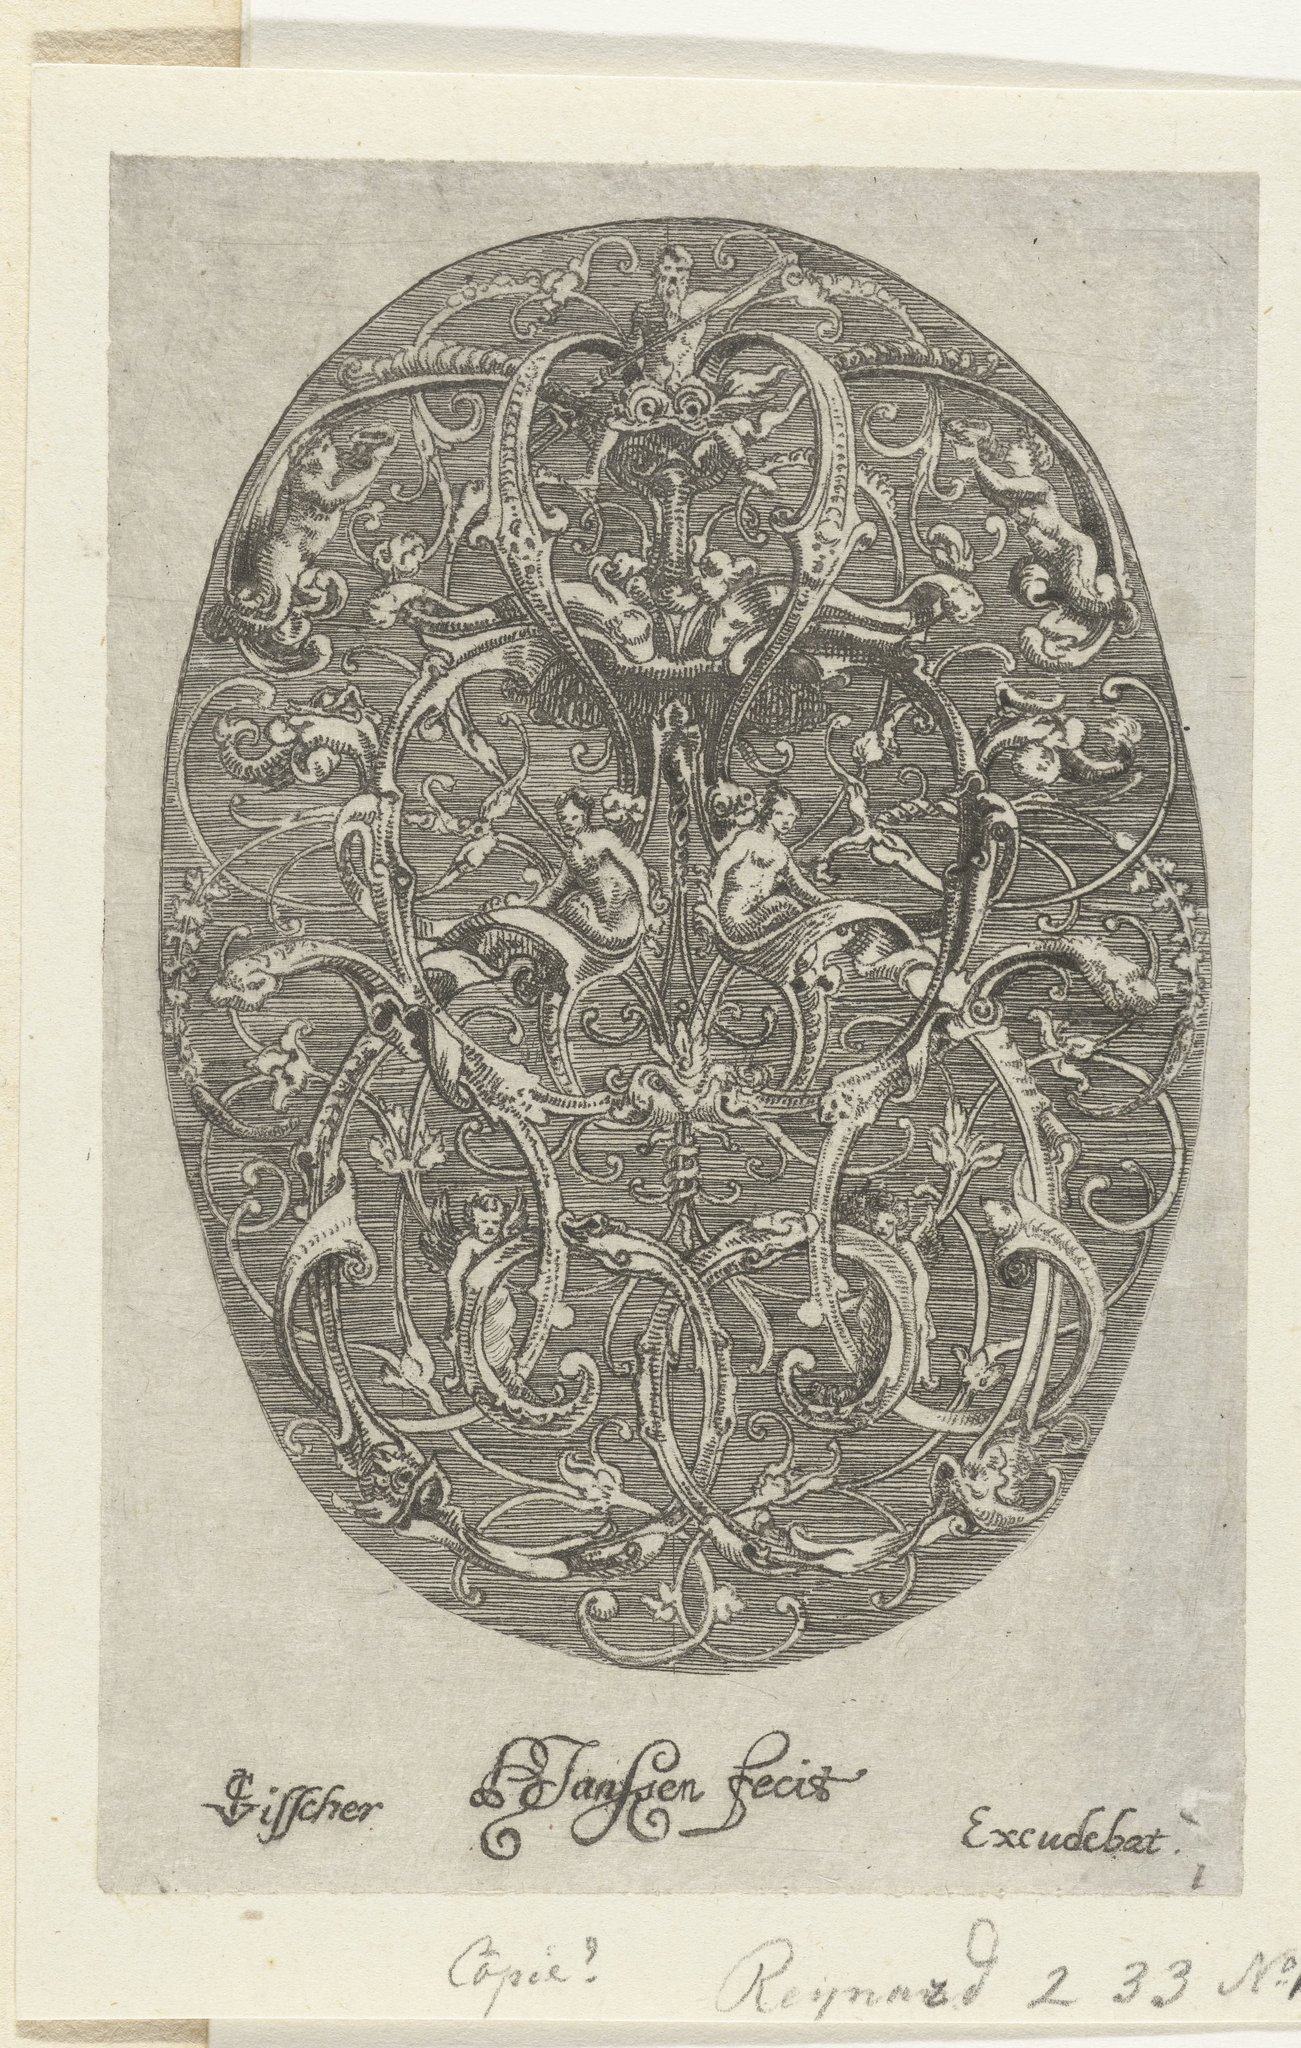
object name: ornament print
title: Ovaal met het element water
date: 1615-1630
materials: paper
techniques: etching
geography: amsterdam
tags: (story of) neptune (poseidon), scrollwork, strapwork ~ ornament, water (one of the four elements)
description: Ovaal met ornamentele ranken en bladranken. Bovenaan zit Neptunus. Tweede editie.